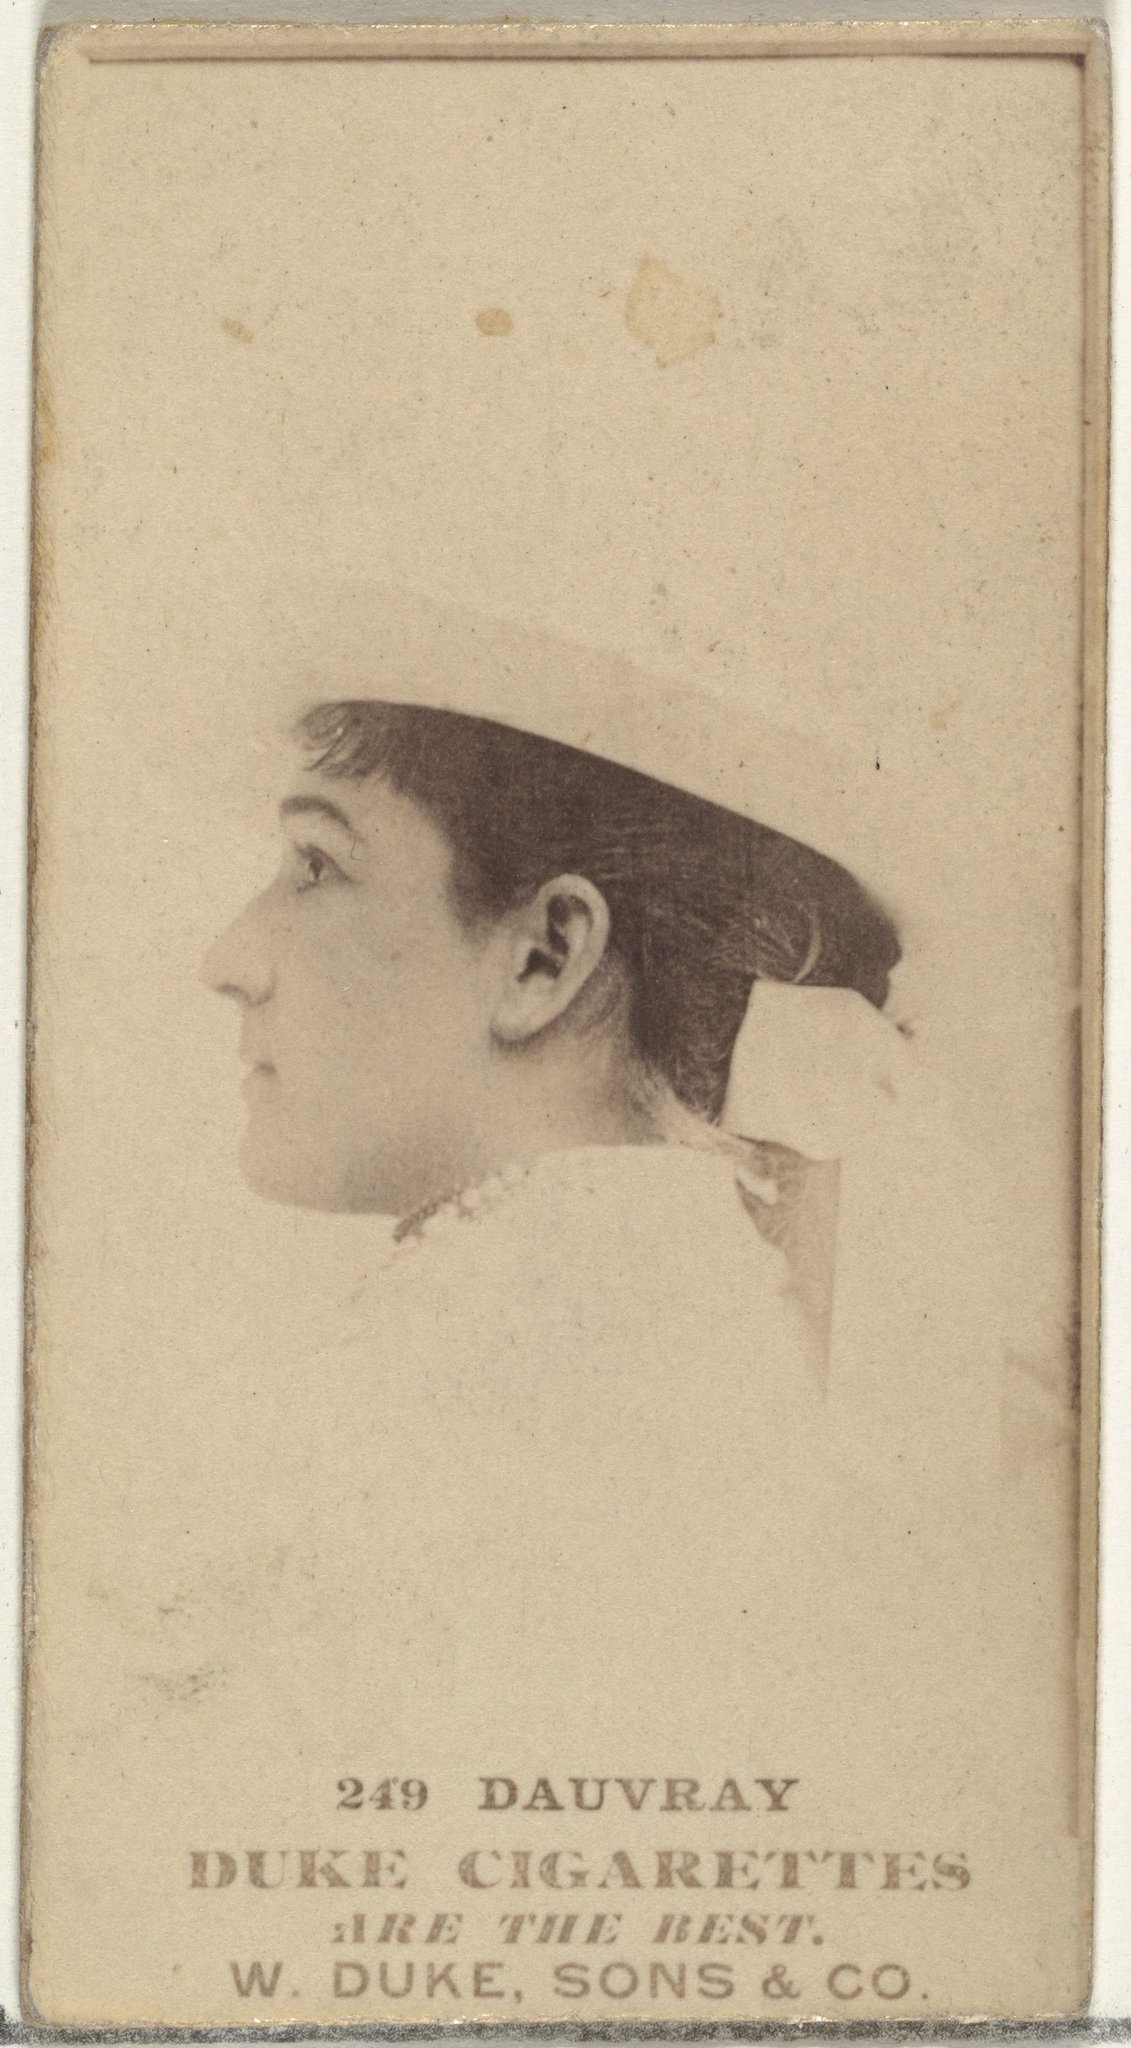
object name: photograph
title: Card Number 249, Miss Dauvray, from the Actors and Actresses series (N145-7) issued by Duke Sons & Co. to promote Duke Cigarettes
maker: w. duke, sons & co.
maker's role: publisher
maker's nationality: american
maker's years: 1870-1920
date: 1880-1889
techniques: albumen silver print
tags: women,actresses